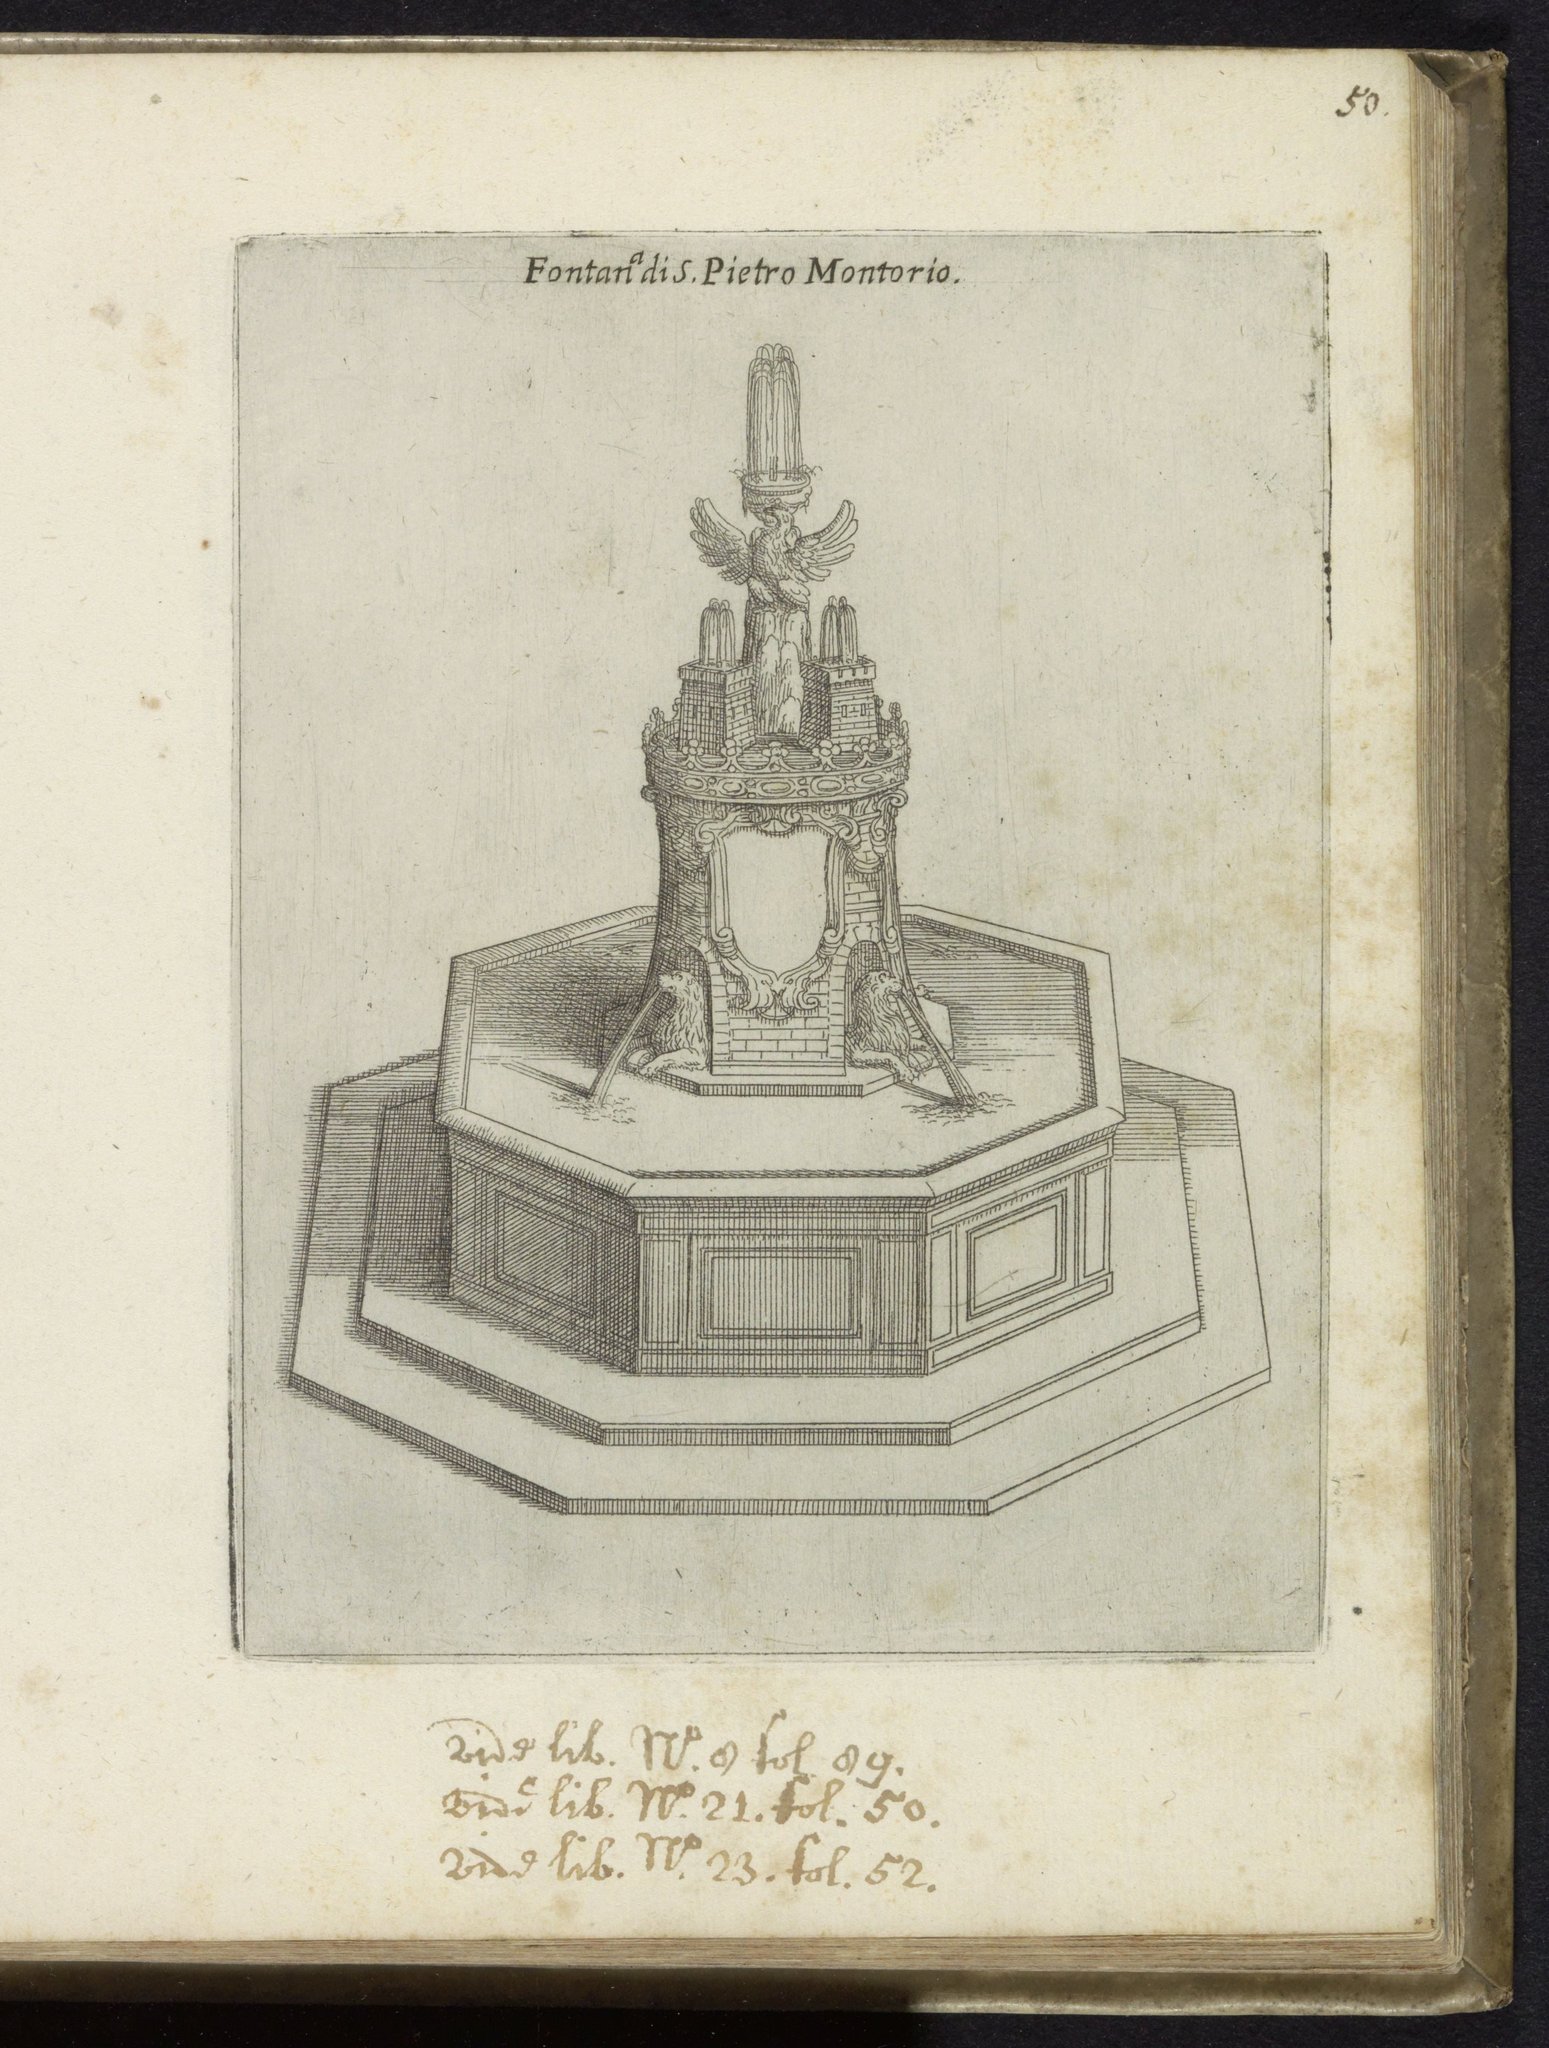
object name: album leaf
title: Raccolta delle principali fontane dell'inclitta città di Roma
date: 1637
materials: paper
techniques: etching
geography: rome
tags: ornamental fountain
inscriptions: inscription: ‘Ende lib. No. 8 fol. 105./ Ende lib. No. 21. fol. 475 et 476./ Ende lib. No. 23. fol. 163. et 164.’, number: ‘50’, inscription: ‘Ende lib. No. 8 fol. 101/ Ende lib. No. 21. fol. 176./ Ende lib. No. 23. fol. 277.’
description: Deze prent maakt deel uit van een reeks van ten minste 20 prenten (+ titelprent) van fonteinen in Rome.